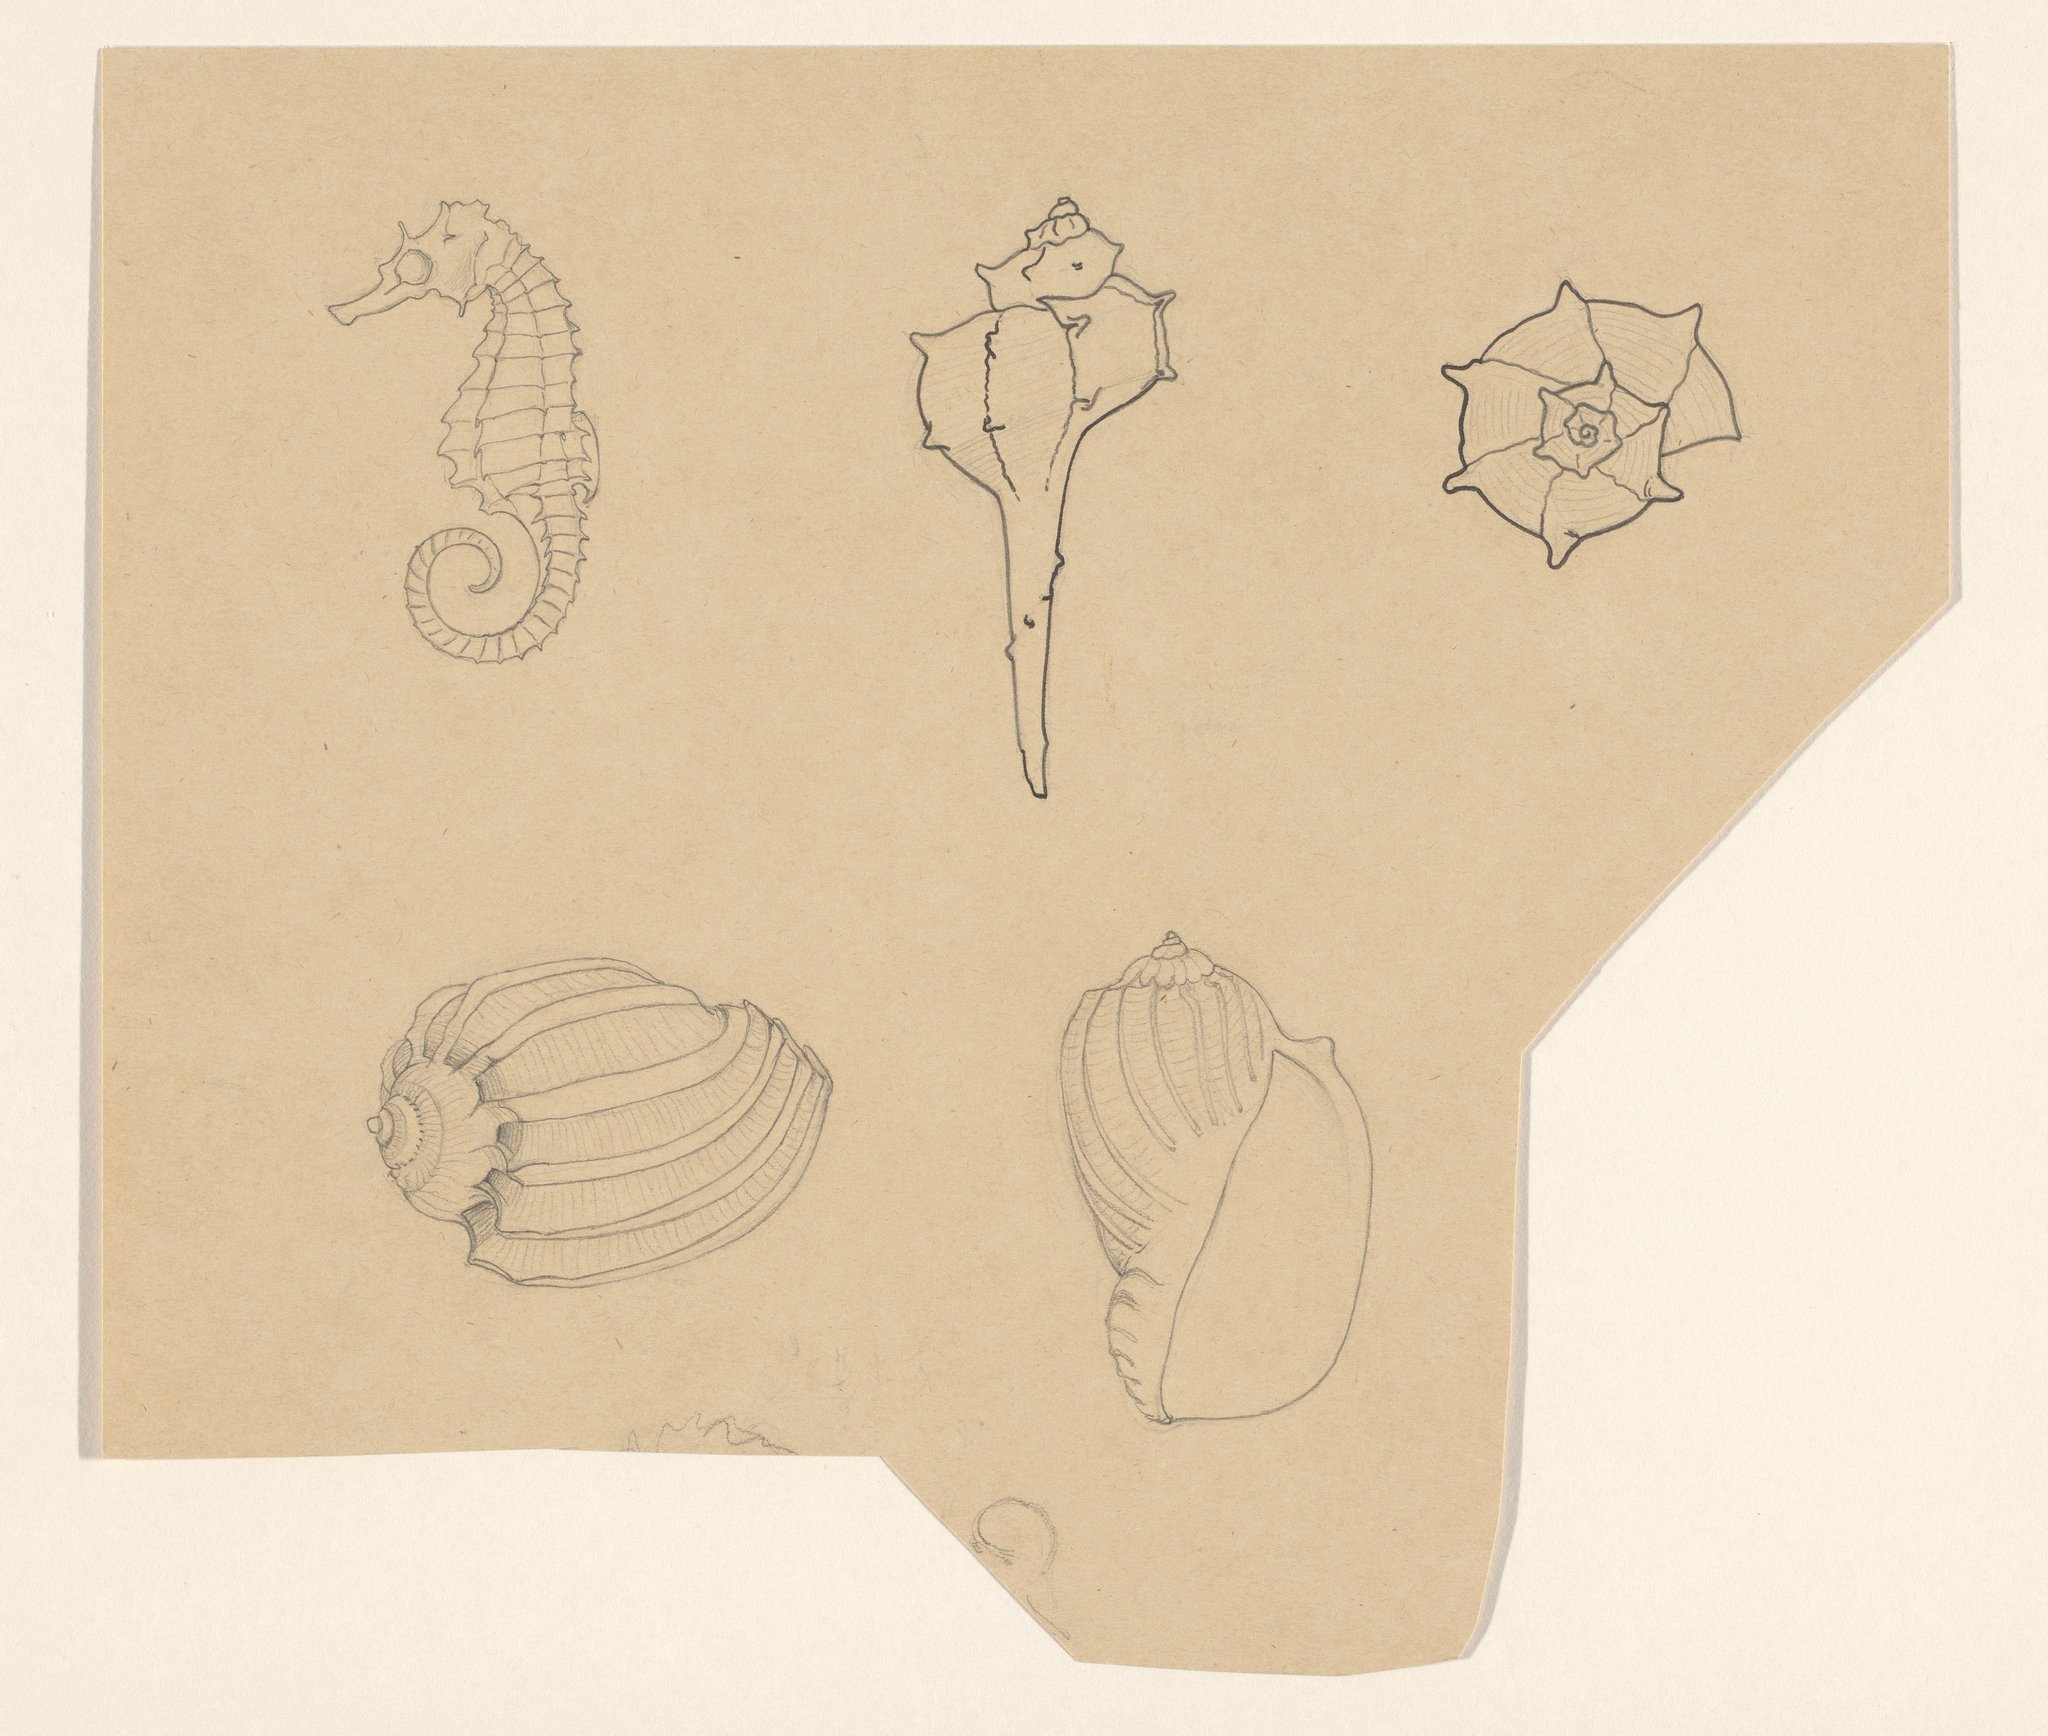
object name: drawing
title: Studieblad met schelpen en een zeepaardje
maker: julie de graag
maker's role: draughtsman, print maker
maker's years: 1877-1924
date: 1887-1924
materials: paper, pencil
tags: bony fishes: seahorse, molluscs (+ shell, snail-shell etc.)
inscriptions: inscription: ‘RP’, number: ‘161’